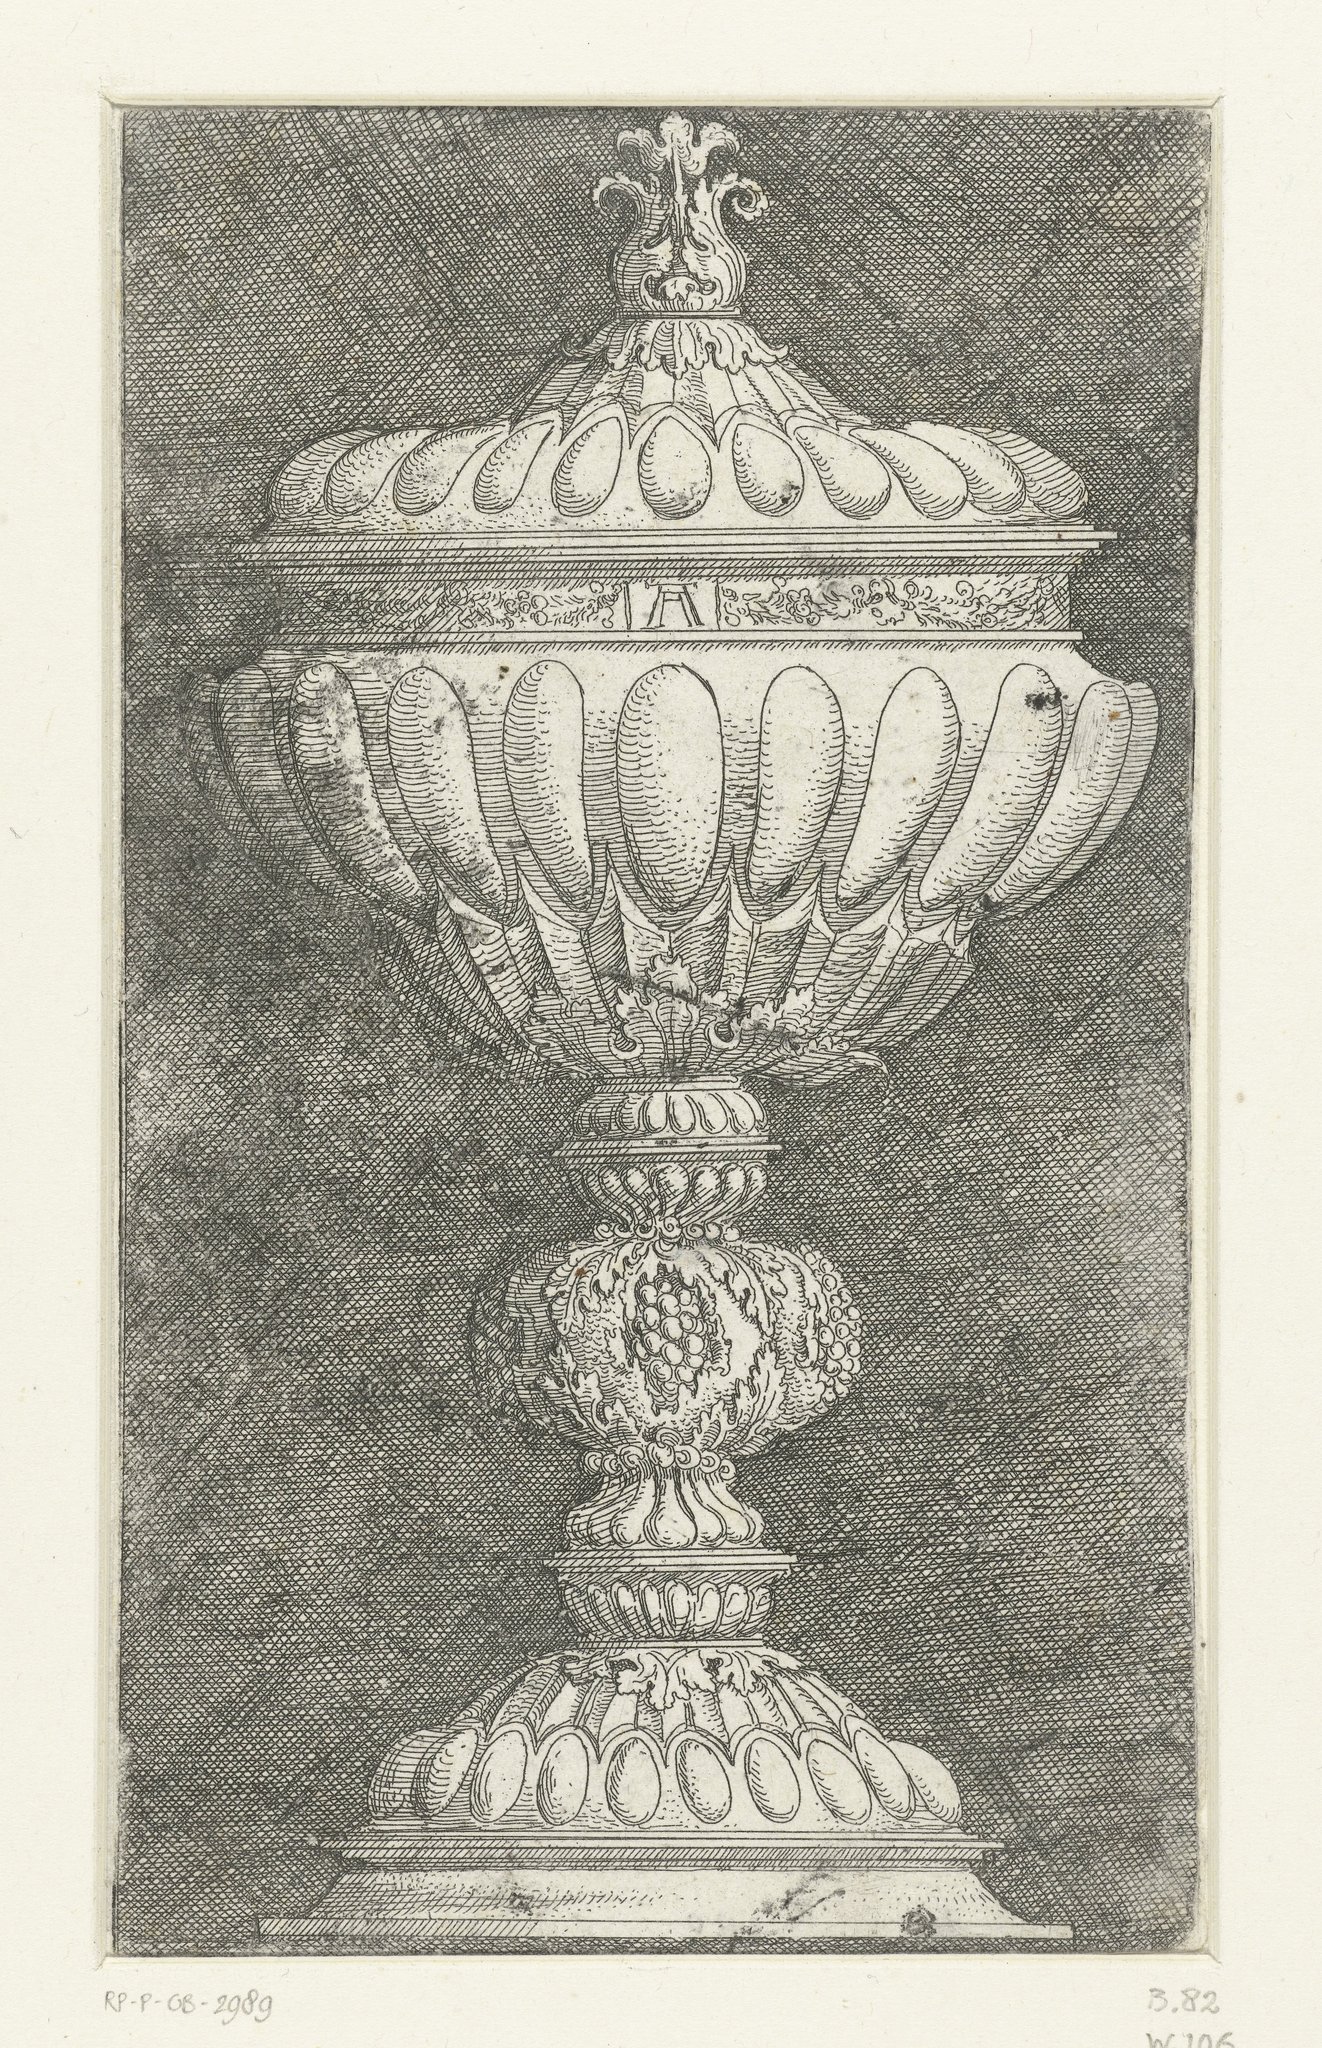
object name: print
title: Vazen, kannen en bokalen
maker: albrecht altdorfer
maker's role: draughtsman, print maker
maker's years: 1480-1538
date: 1506-1538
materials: paper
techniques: etching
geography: germany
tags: mug, beaker, goblet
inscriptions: number: ‘90’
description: Bokaal met deksel. De stam heeft een nodus, gedecoreerd met drie granaatappels. Uit een serie van 22 bladen met vazen, kannen en bokalen.